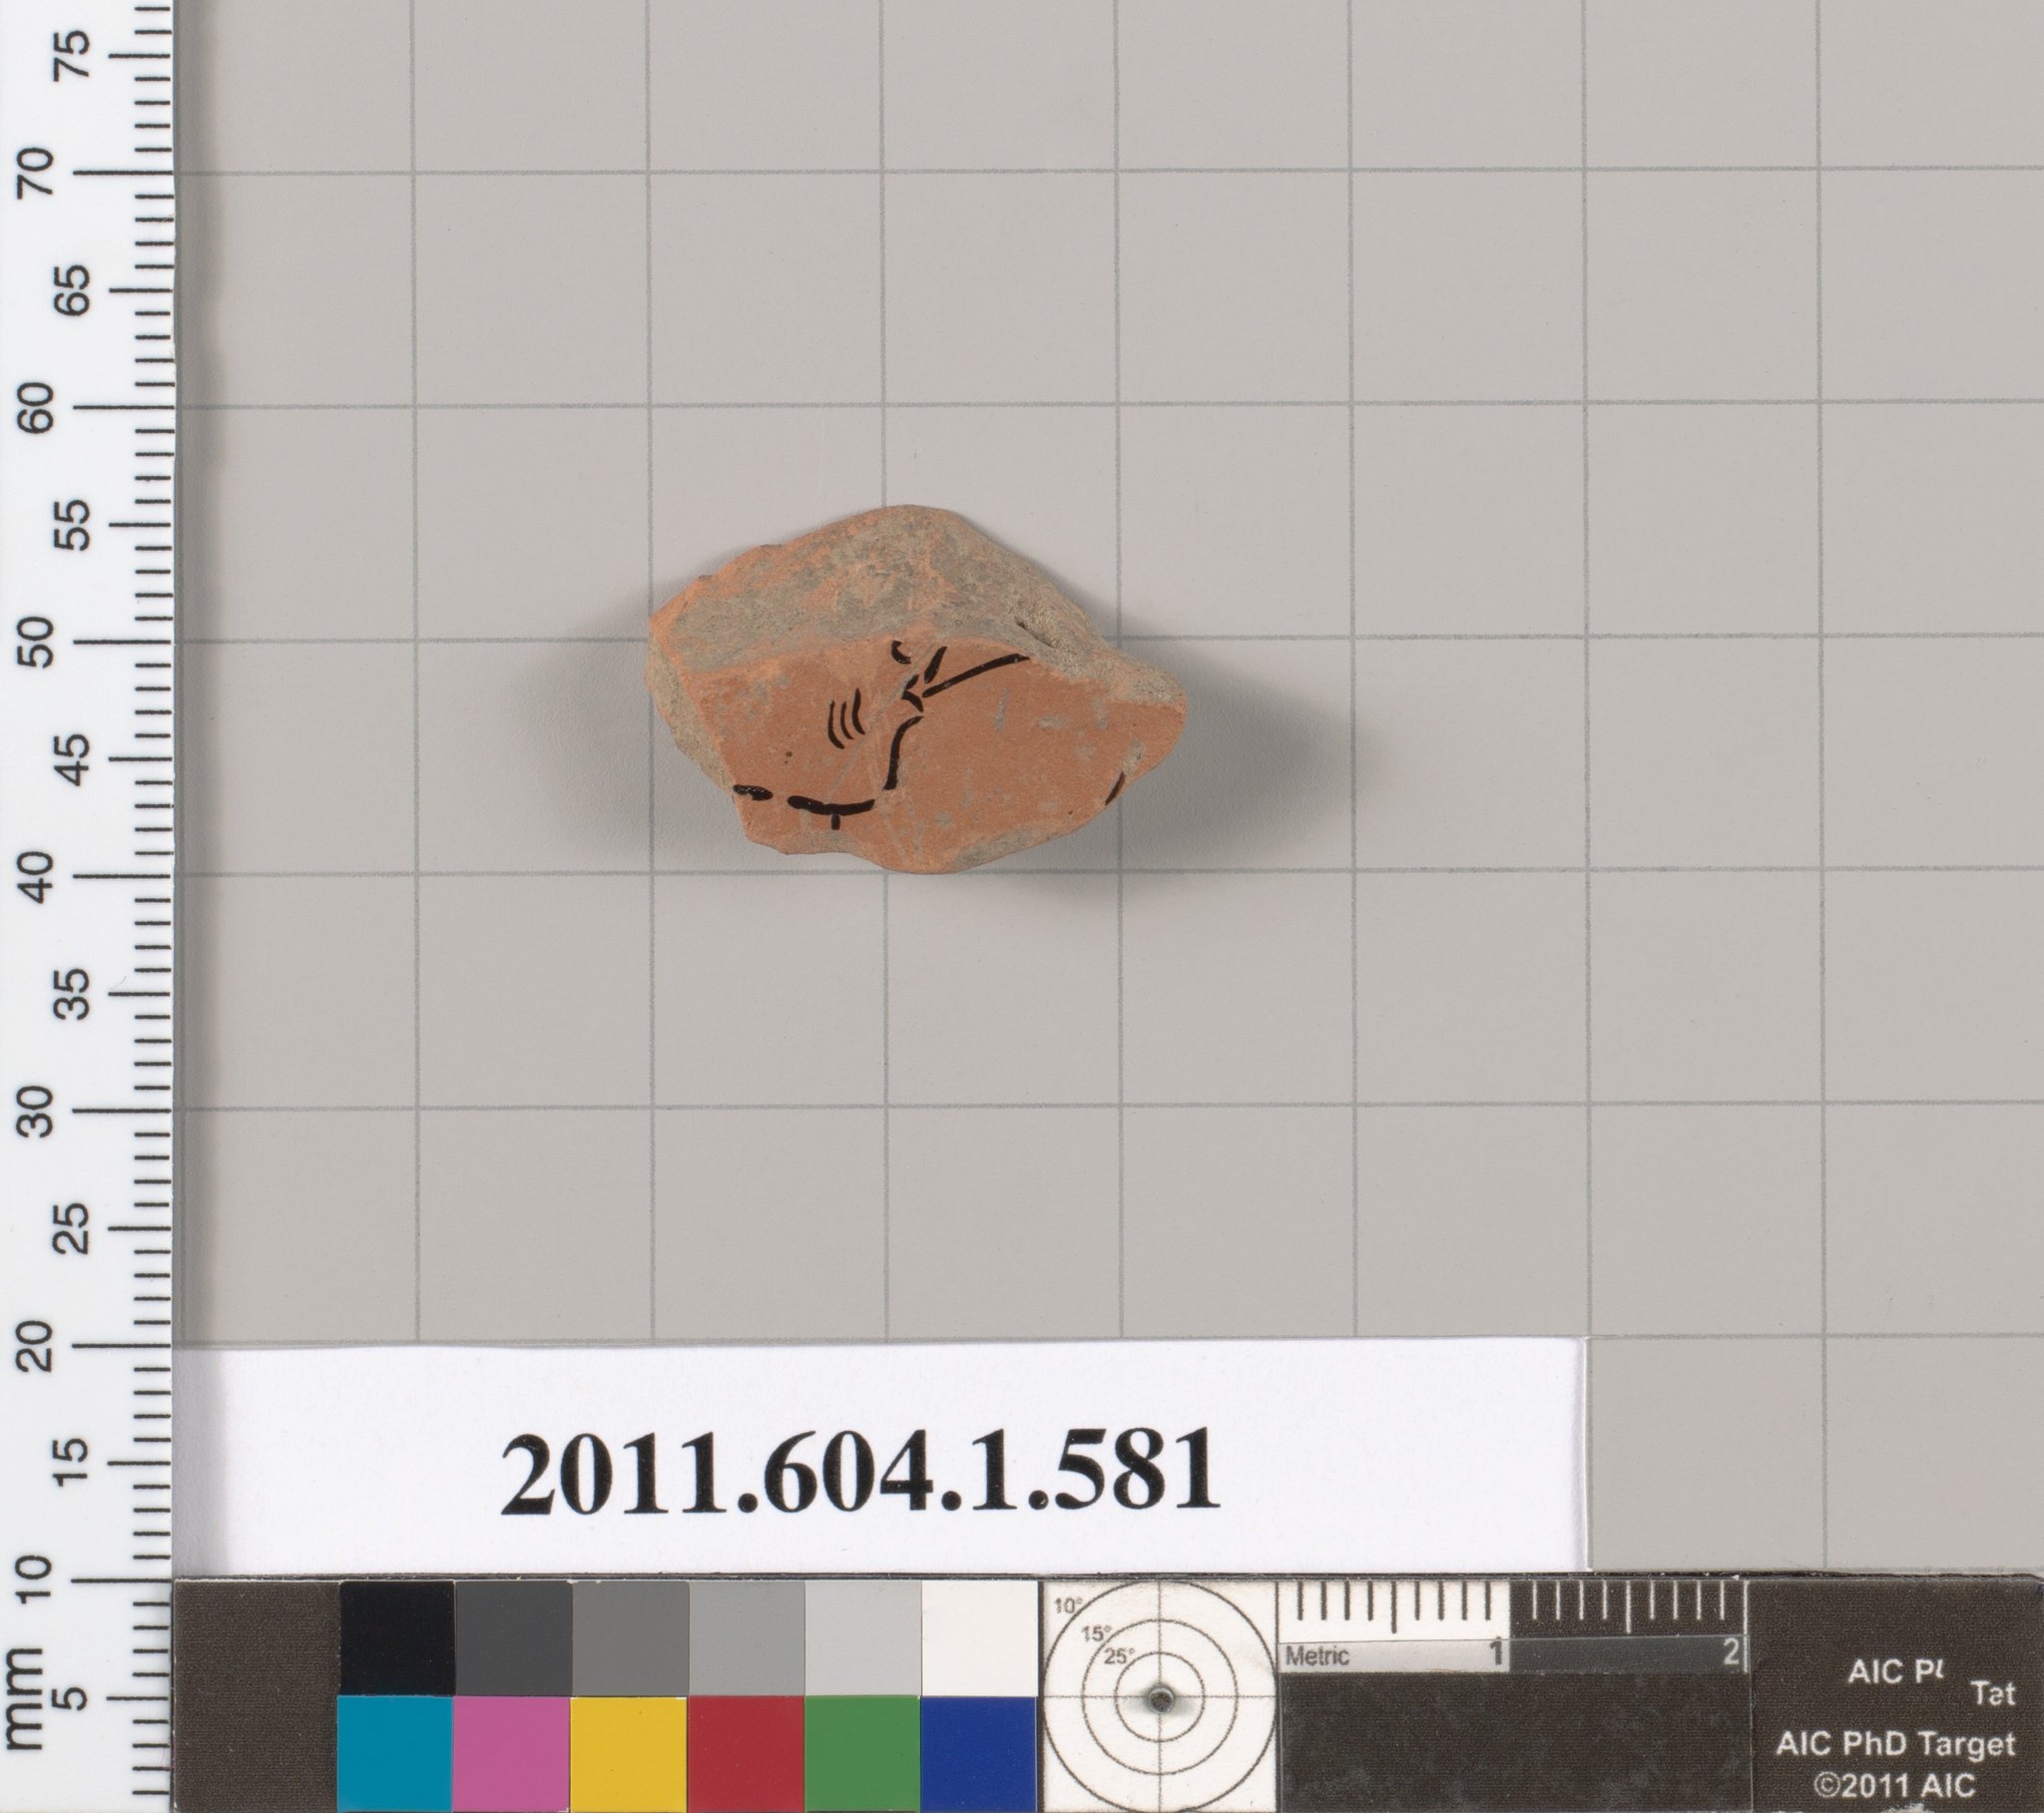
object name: kylix fragment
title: Terracotta fragment of a kylix (drinking cup)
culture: greek, attic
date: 490-480 BCE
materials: terracotta